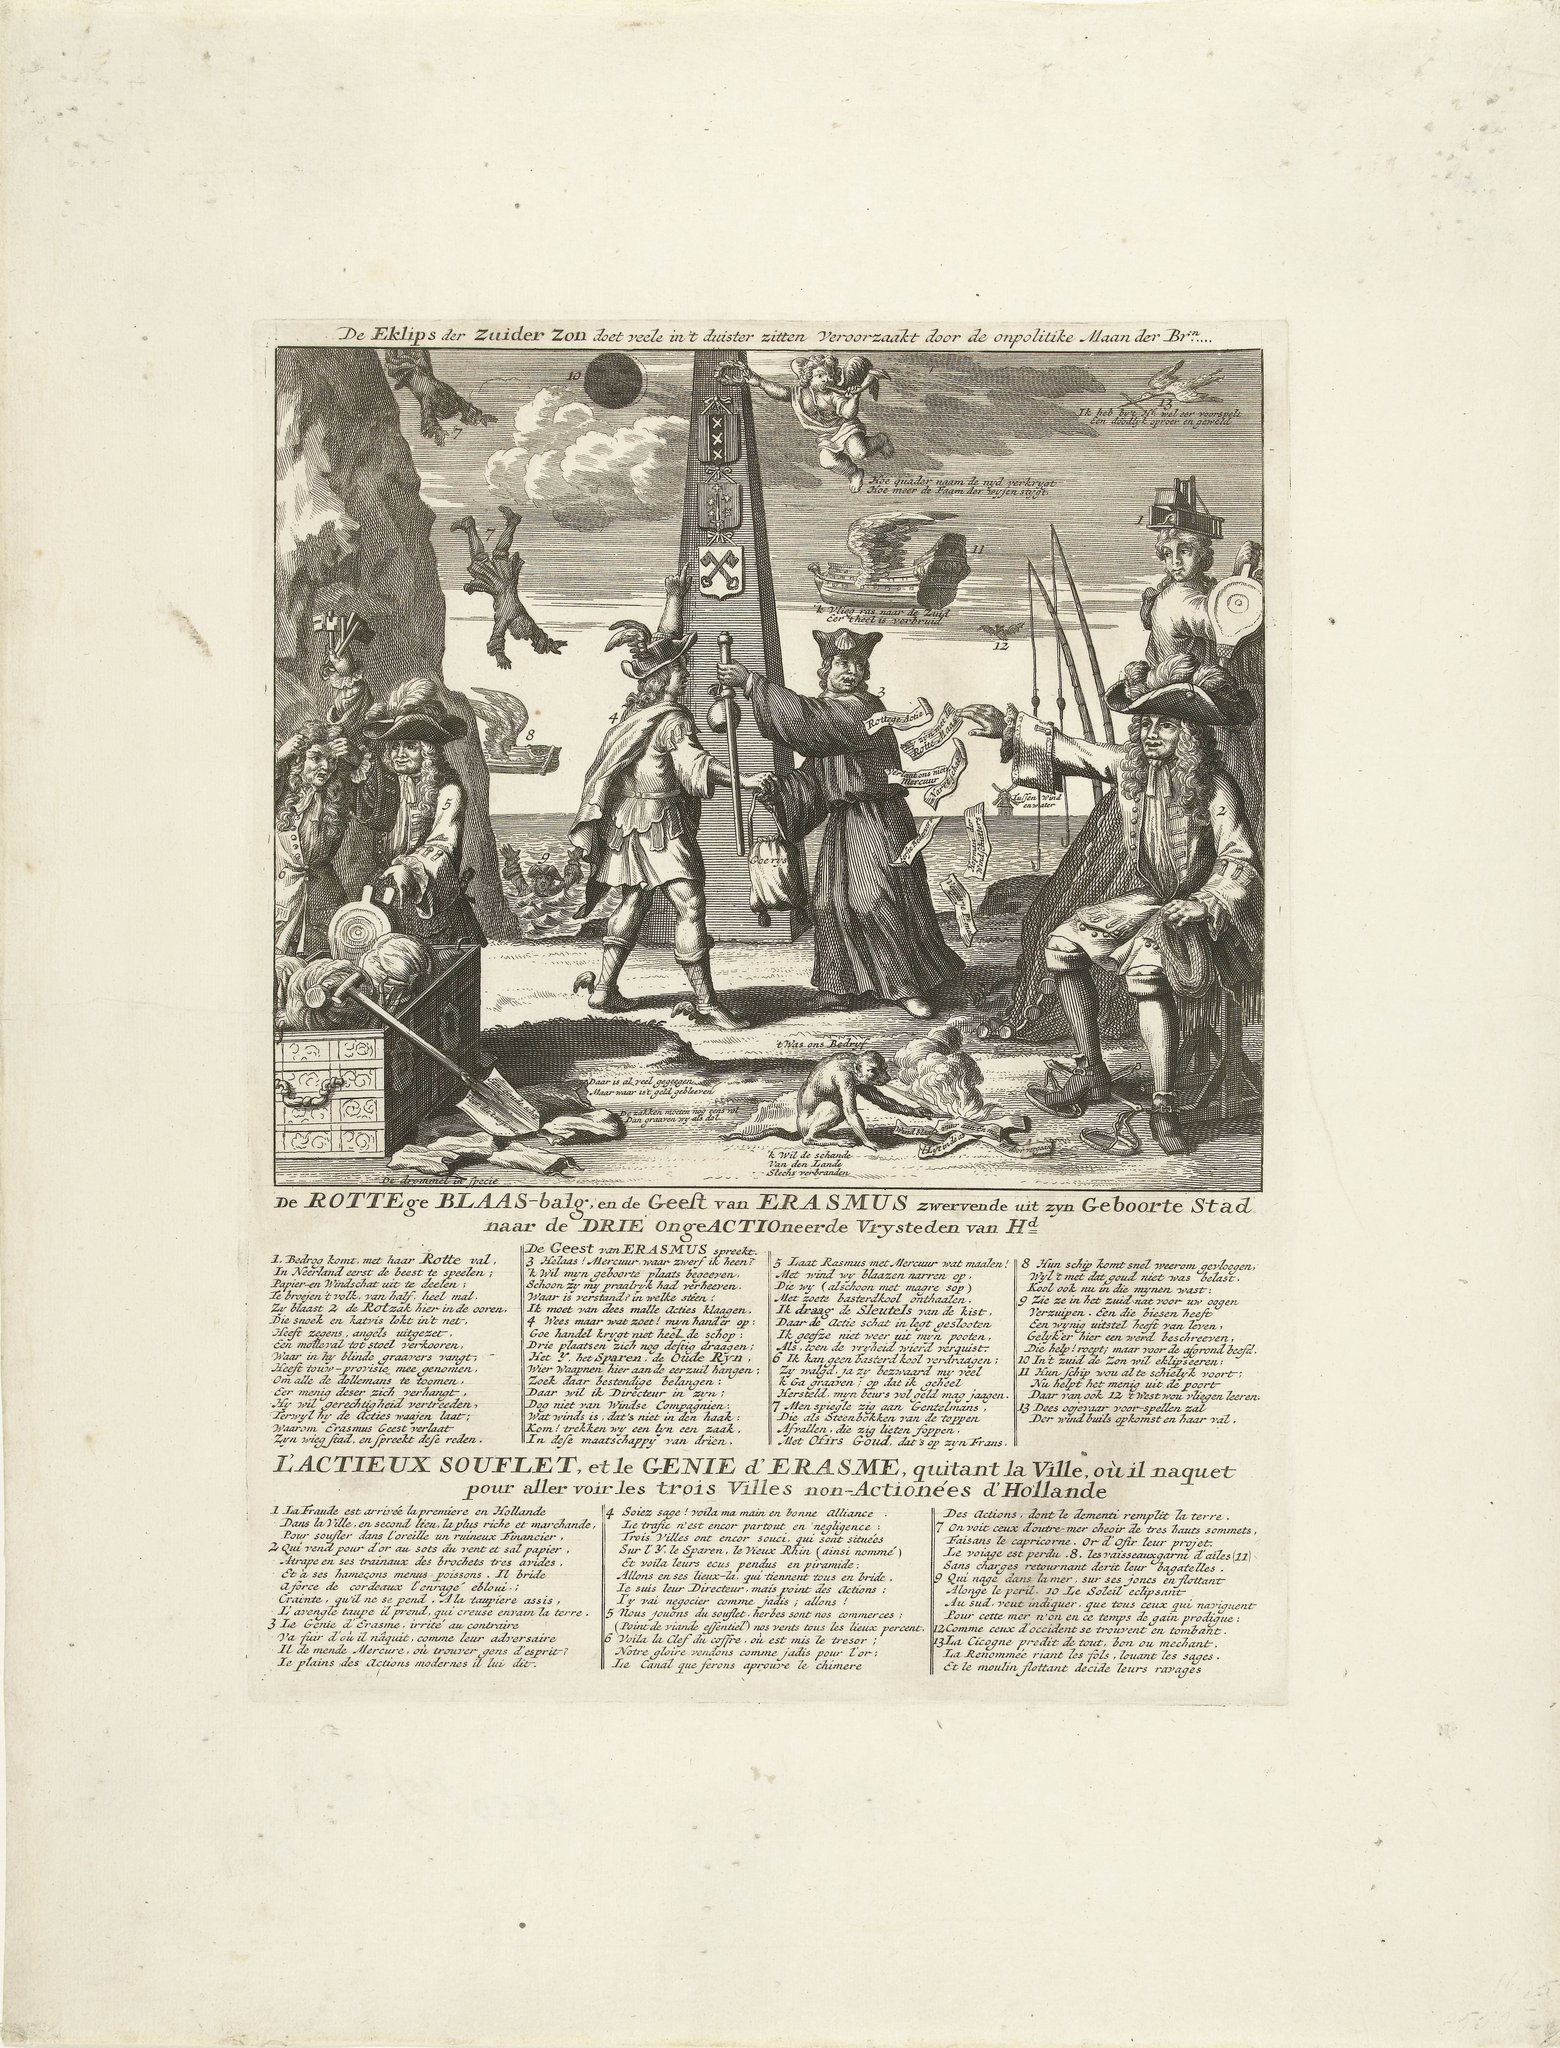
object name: cartoon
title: De geest van Erasmus verlaat Rotterdam, 1720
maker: Anonymous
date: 1720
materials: paper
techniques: etching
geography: northern netherlands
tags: rotterdam, desiderius erasmus, financial panic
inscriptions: collector's mark: Lugt 2228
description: De windhandel te Rotterdam doet de geest van Erasmus de stad verlaten, 1720. Spotprent op de windhandel te Rotterdam. Rechts op de voorgrond vertreedt een welgestelde Rotterdamer de weegschalen van de Rechtvaardigheid, links blijkt de schatkist bij inspectie slechts kolen te bevatten. In het onderschrift verzen in het Nederlands en Frans. Prent 15 in de serie Het Groote Tafereel der Dwaasheid met spotprenten op de Windhandel of Actiehandel van 1720.